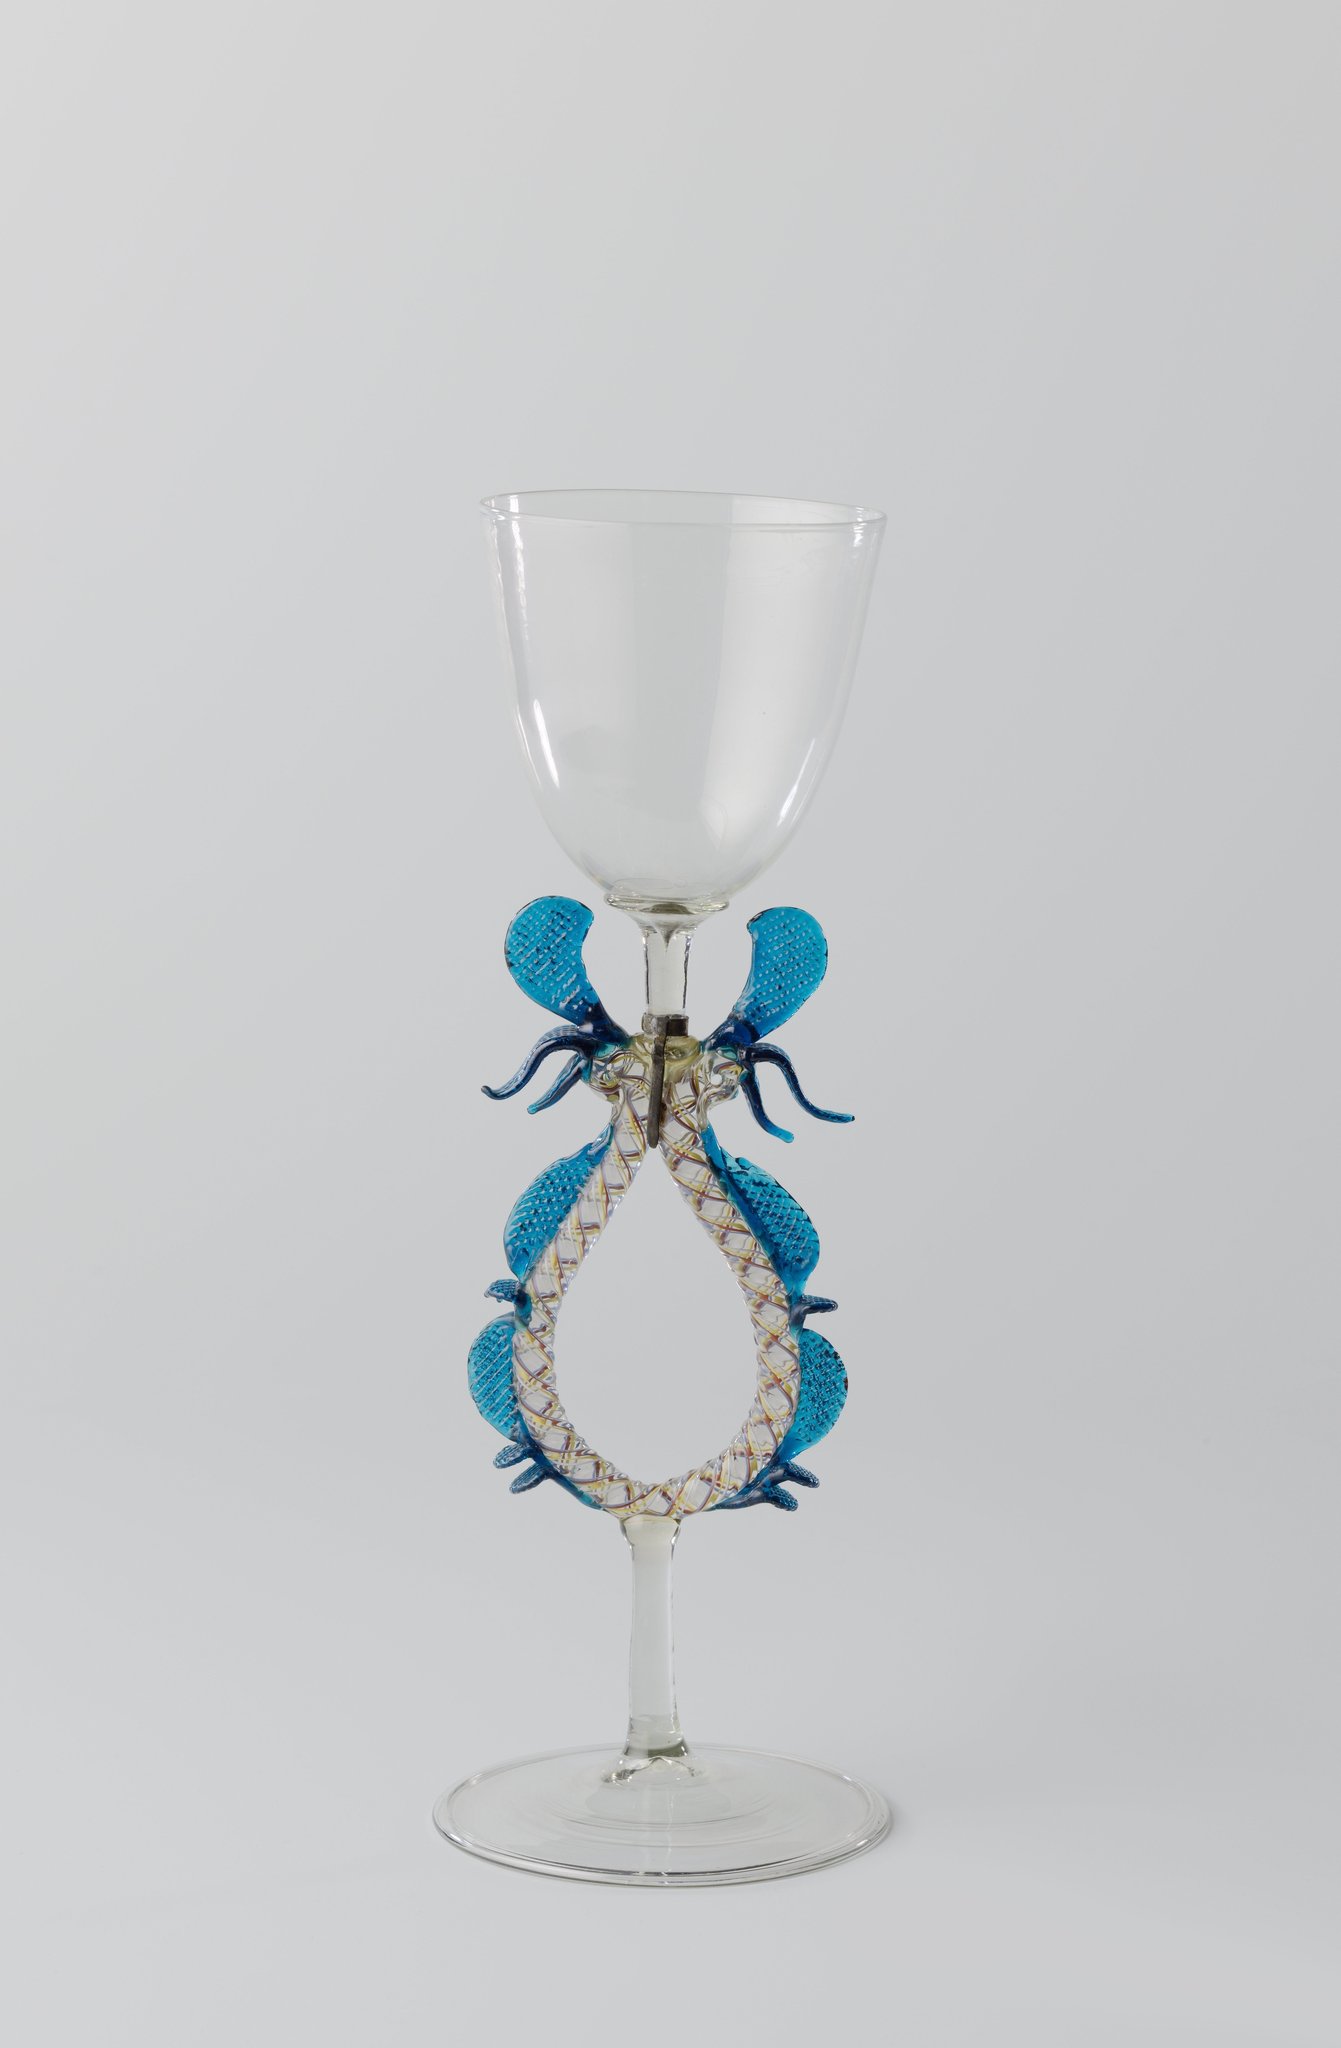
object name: vleugelglas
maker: c.h.f. müller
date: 1865-1870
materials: glass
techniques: façon de venise, glassblowing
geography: hamburg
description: Vleugelglas met platte voet met omgeslagen rand. De stam opgebouwd uit een recht staaf van kleurloos glas en een gebogen staaf met een slinger van rode, gele, witte en blauwe draden, bezet met blauwe vleugels, eindigend in een grote vleugel. Op een recht, kleurloos verbindingsstuk een kleine, gebogen kelk.